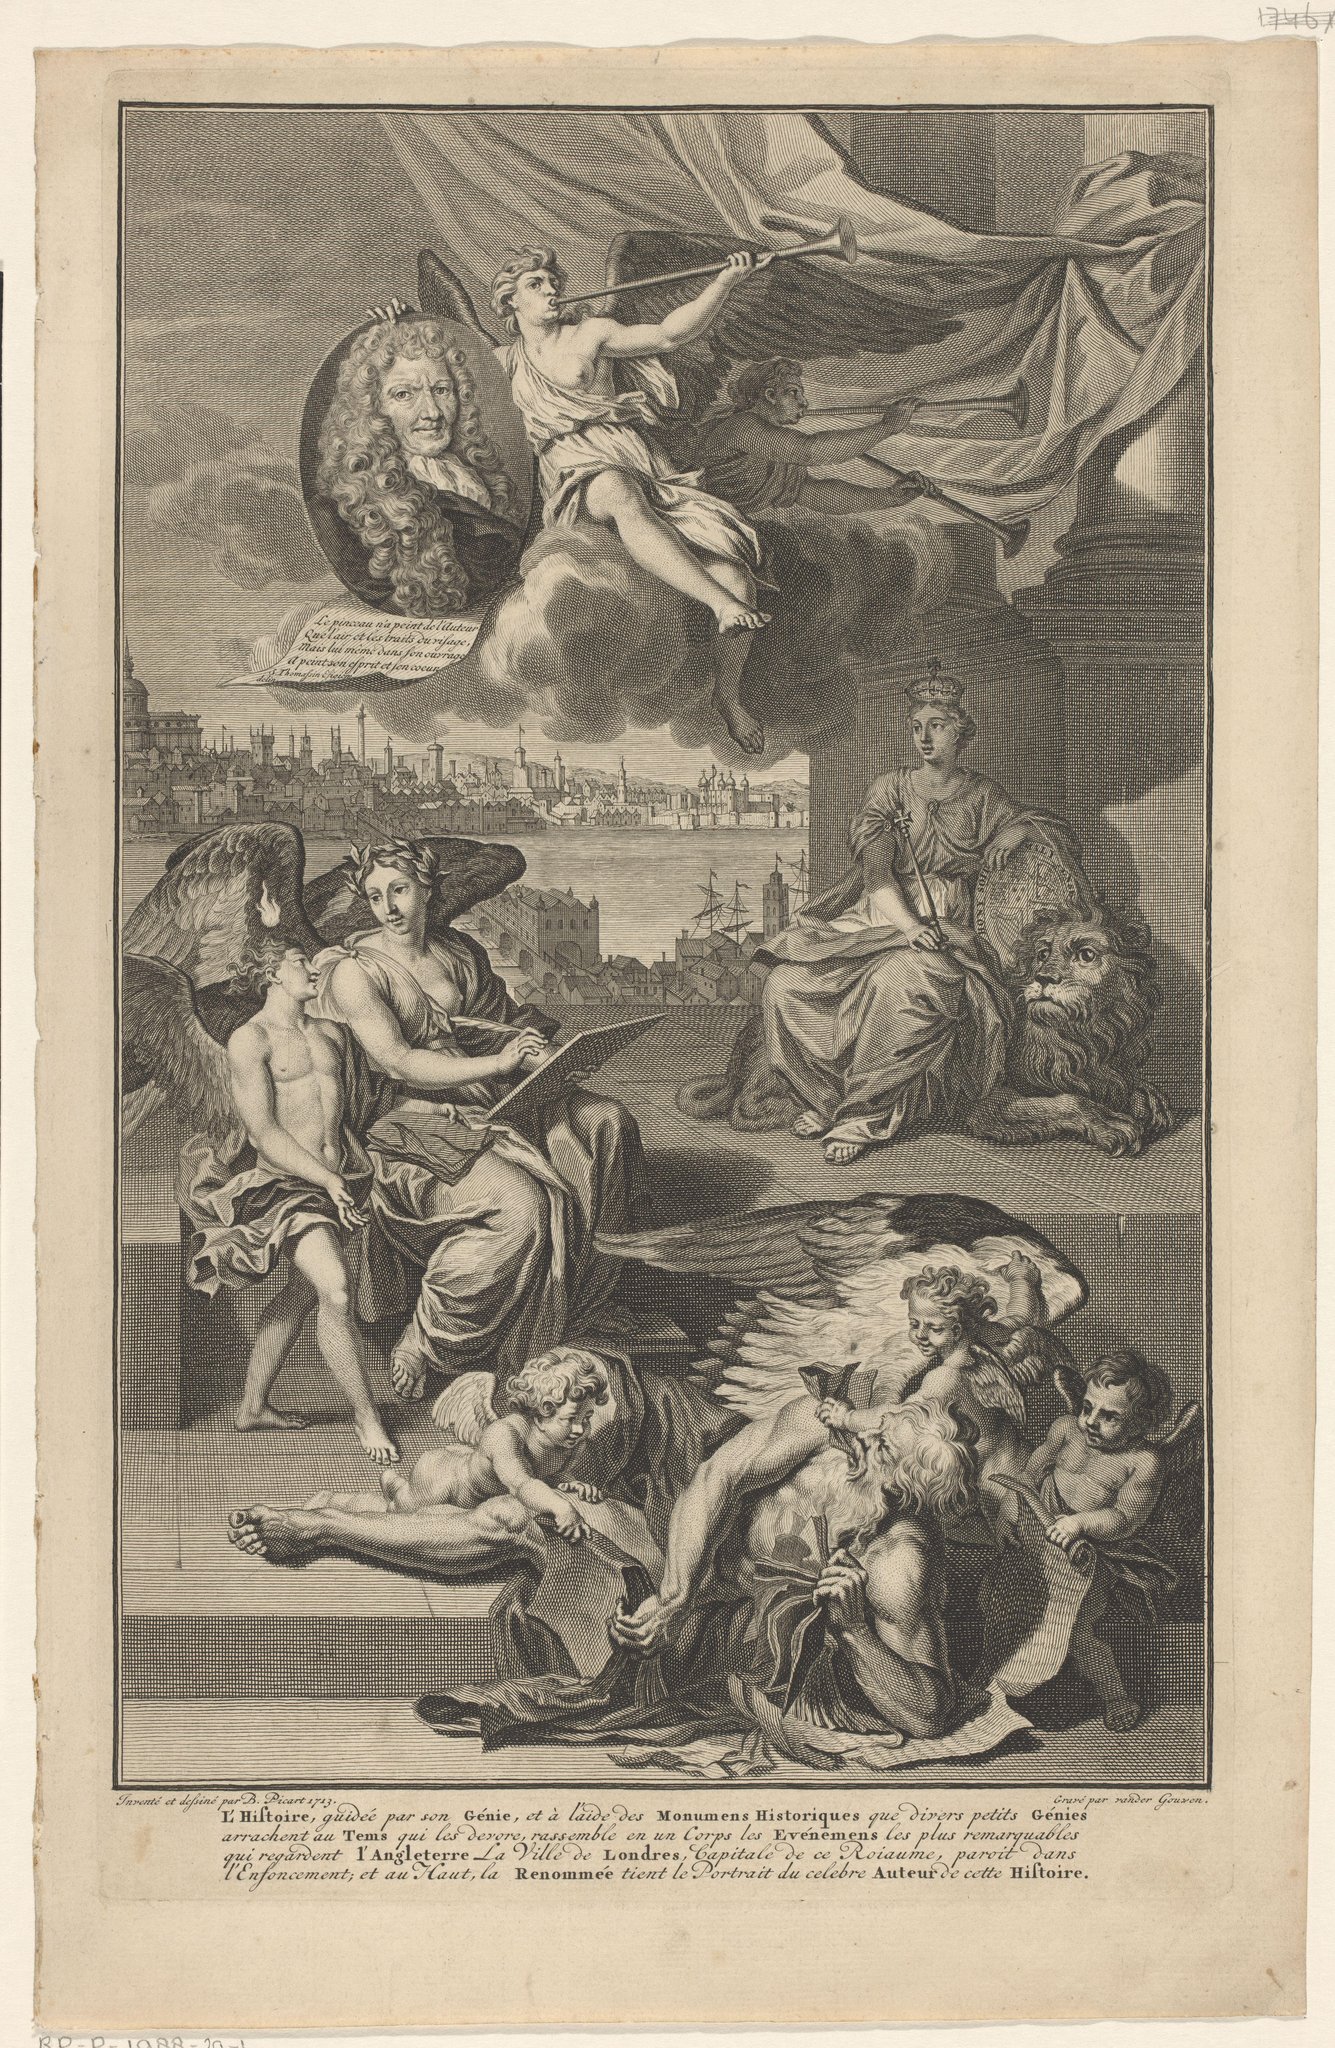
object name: print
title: Titelpagina voor: Isaac de Larrey, Histoire d'Angleterre, 1713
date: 1713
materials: paper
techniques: engraving, etching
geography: rotterdam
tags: berlin, personifications of countries, nations, states, districts, etc., portrait of a writer, 'historia'; 'historia' (ripa)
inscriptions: collector's mark: Lugt 2228, collector's mark: Lugt 2760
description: De personificatie van Geschiedenis, gezeten op de vloer, schrijft samen met de personificatie van Inspiratie de geschiedenis van Groot-Brittannië. Rechts bij een zuil de personificatie van Groot-Brittannië, zittend op een leeuw. In haar handen het wapenschild van Engeland, gebruikt door Karel II en Jacobus II. Op de voorgrond trachten drie putti de gevleugelde Tijd tegen te houden, die boeken verscheurt en opeet. Boven de personificatie van Faam, blazend op een bazuin. Ze draagt het portret in een ovale lijst van de Franse historicus Isaac de Larrey. Op de achtergrond de stad Londen. In de ondermarge een vierregelige Franse tekst.